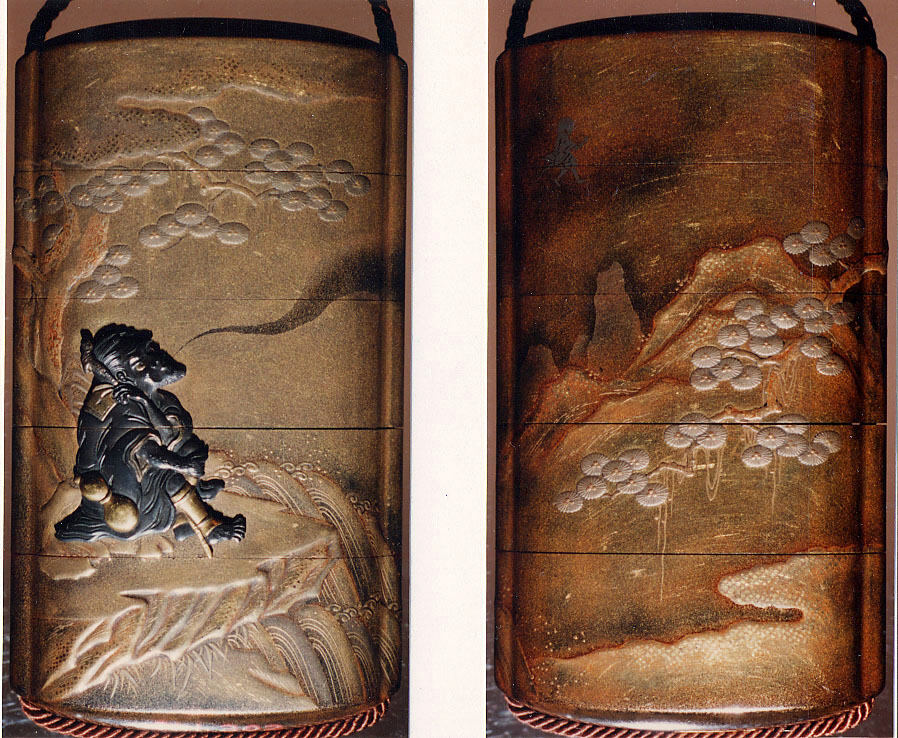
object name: inrō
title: Case (Inrō) with Design of Sage Seated on Rocks beside a Tree, Exhaling His Spirit (obverse); His Spirit Walking on Air (reverse)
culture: japanese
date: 1801-1900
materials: gold, lacquer, metal, silver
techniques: fundame, hiramakie, inlay, maki-e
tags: men,landscapes,trees